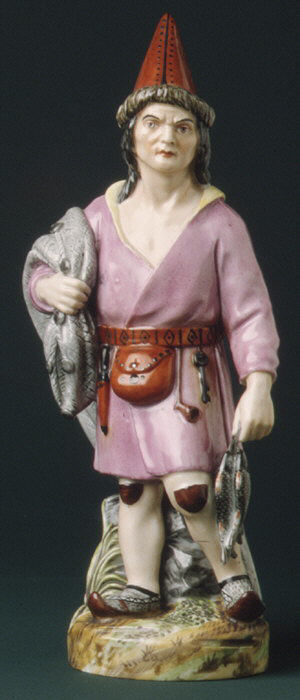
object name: figure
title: Lapplander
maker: imperial porcelain manufactory, st. petersburg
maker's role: manufactory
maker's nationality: russian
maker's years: 1744-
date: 1780-1800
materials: hard paste porcelain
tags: men